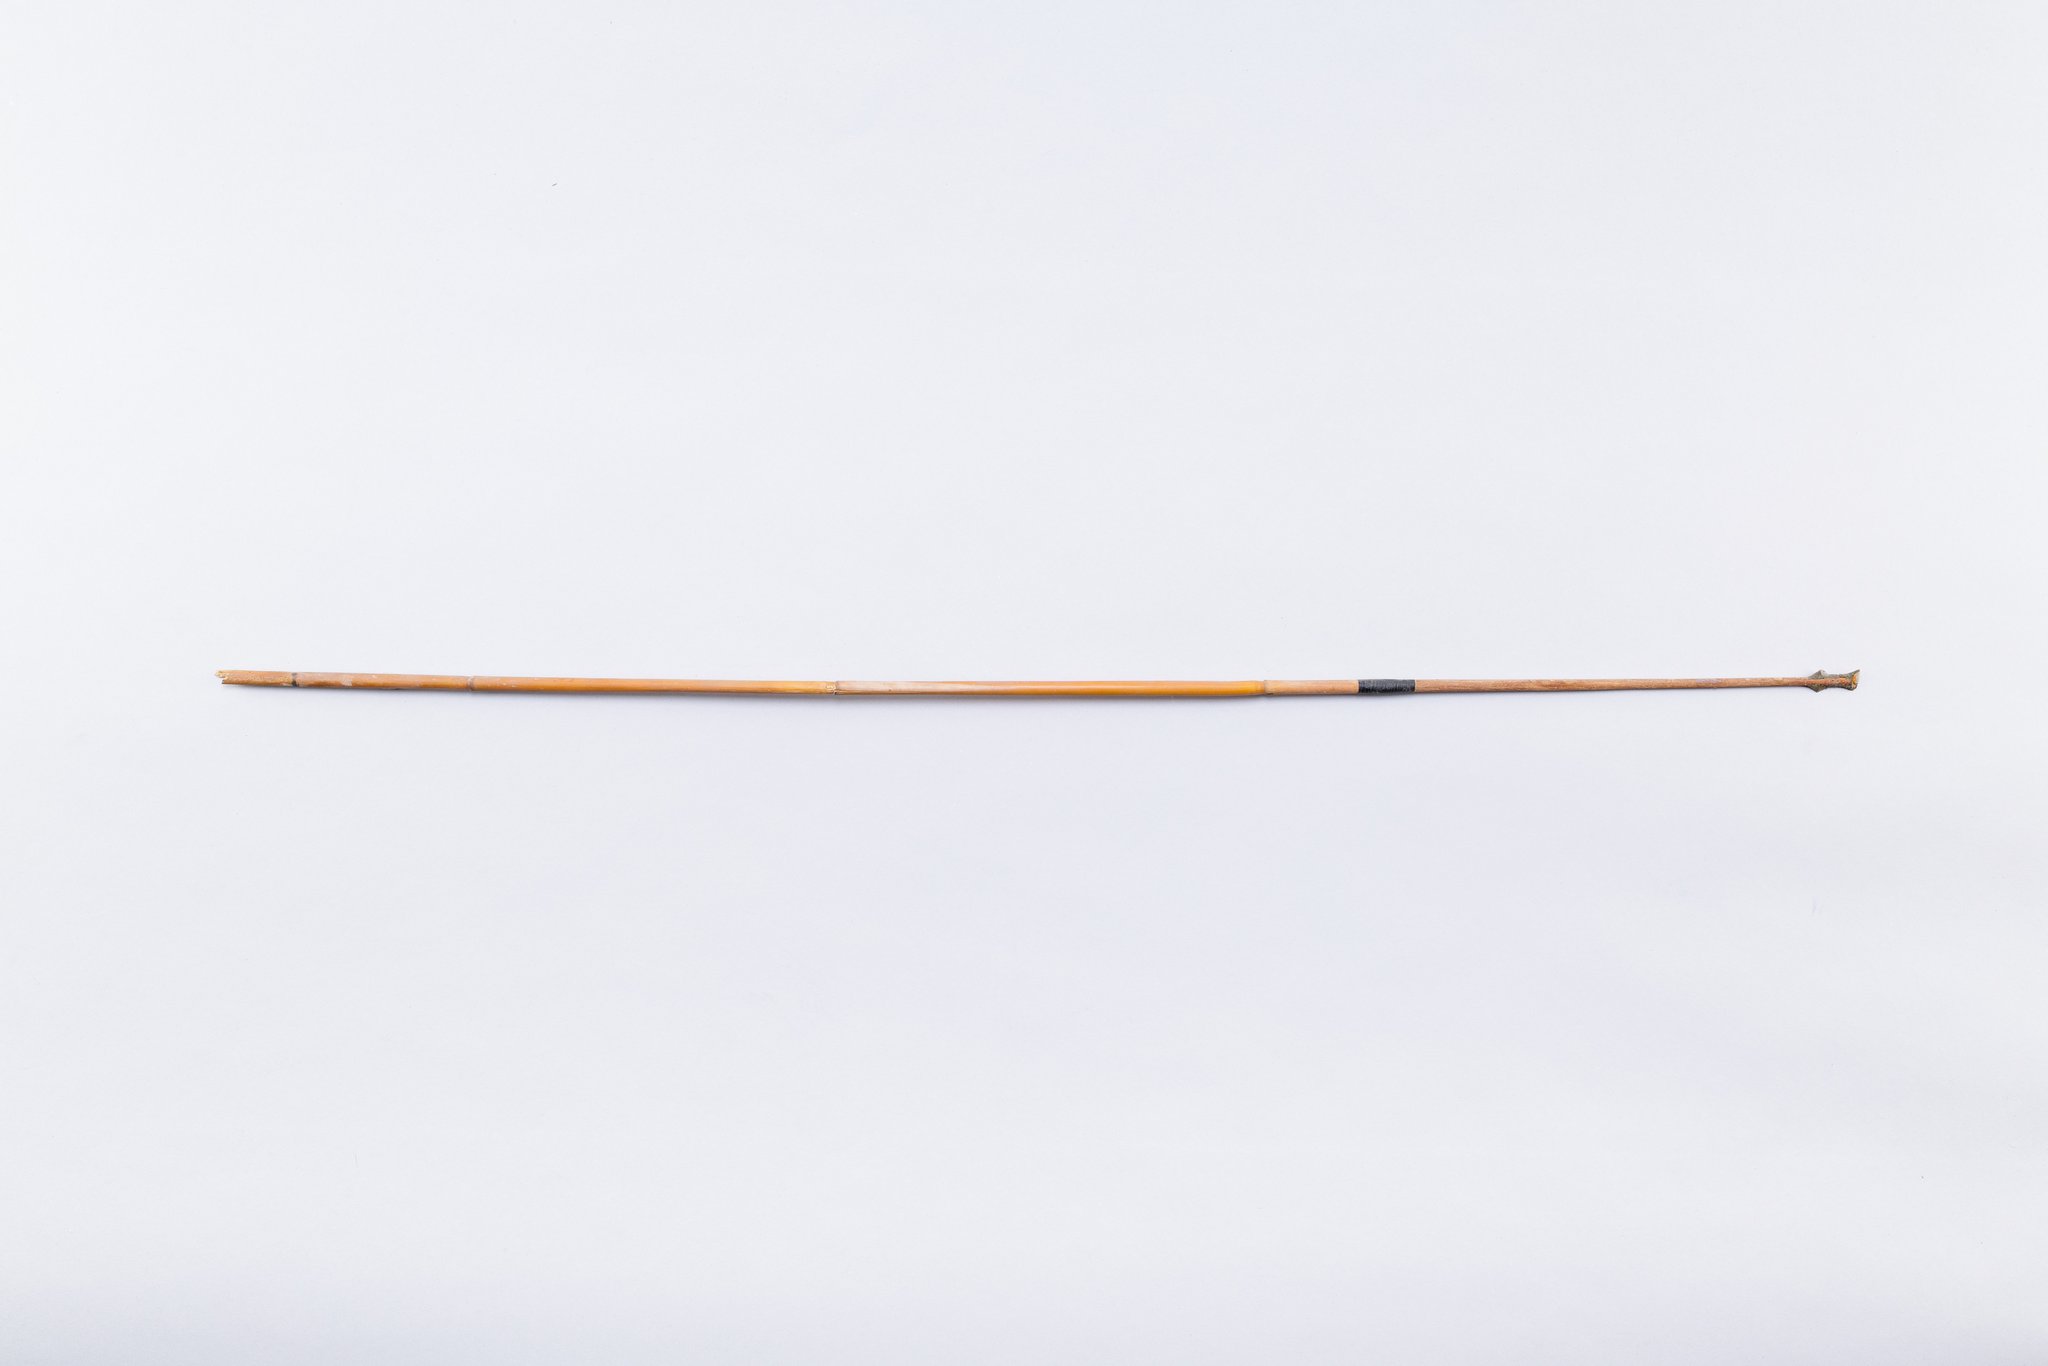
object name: arrow, arrowhead, adhesive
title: Arrow with composite stone tip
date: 1479-1458 BCE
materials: quartz, wood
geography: egypt